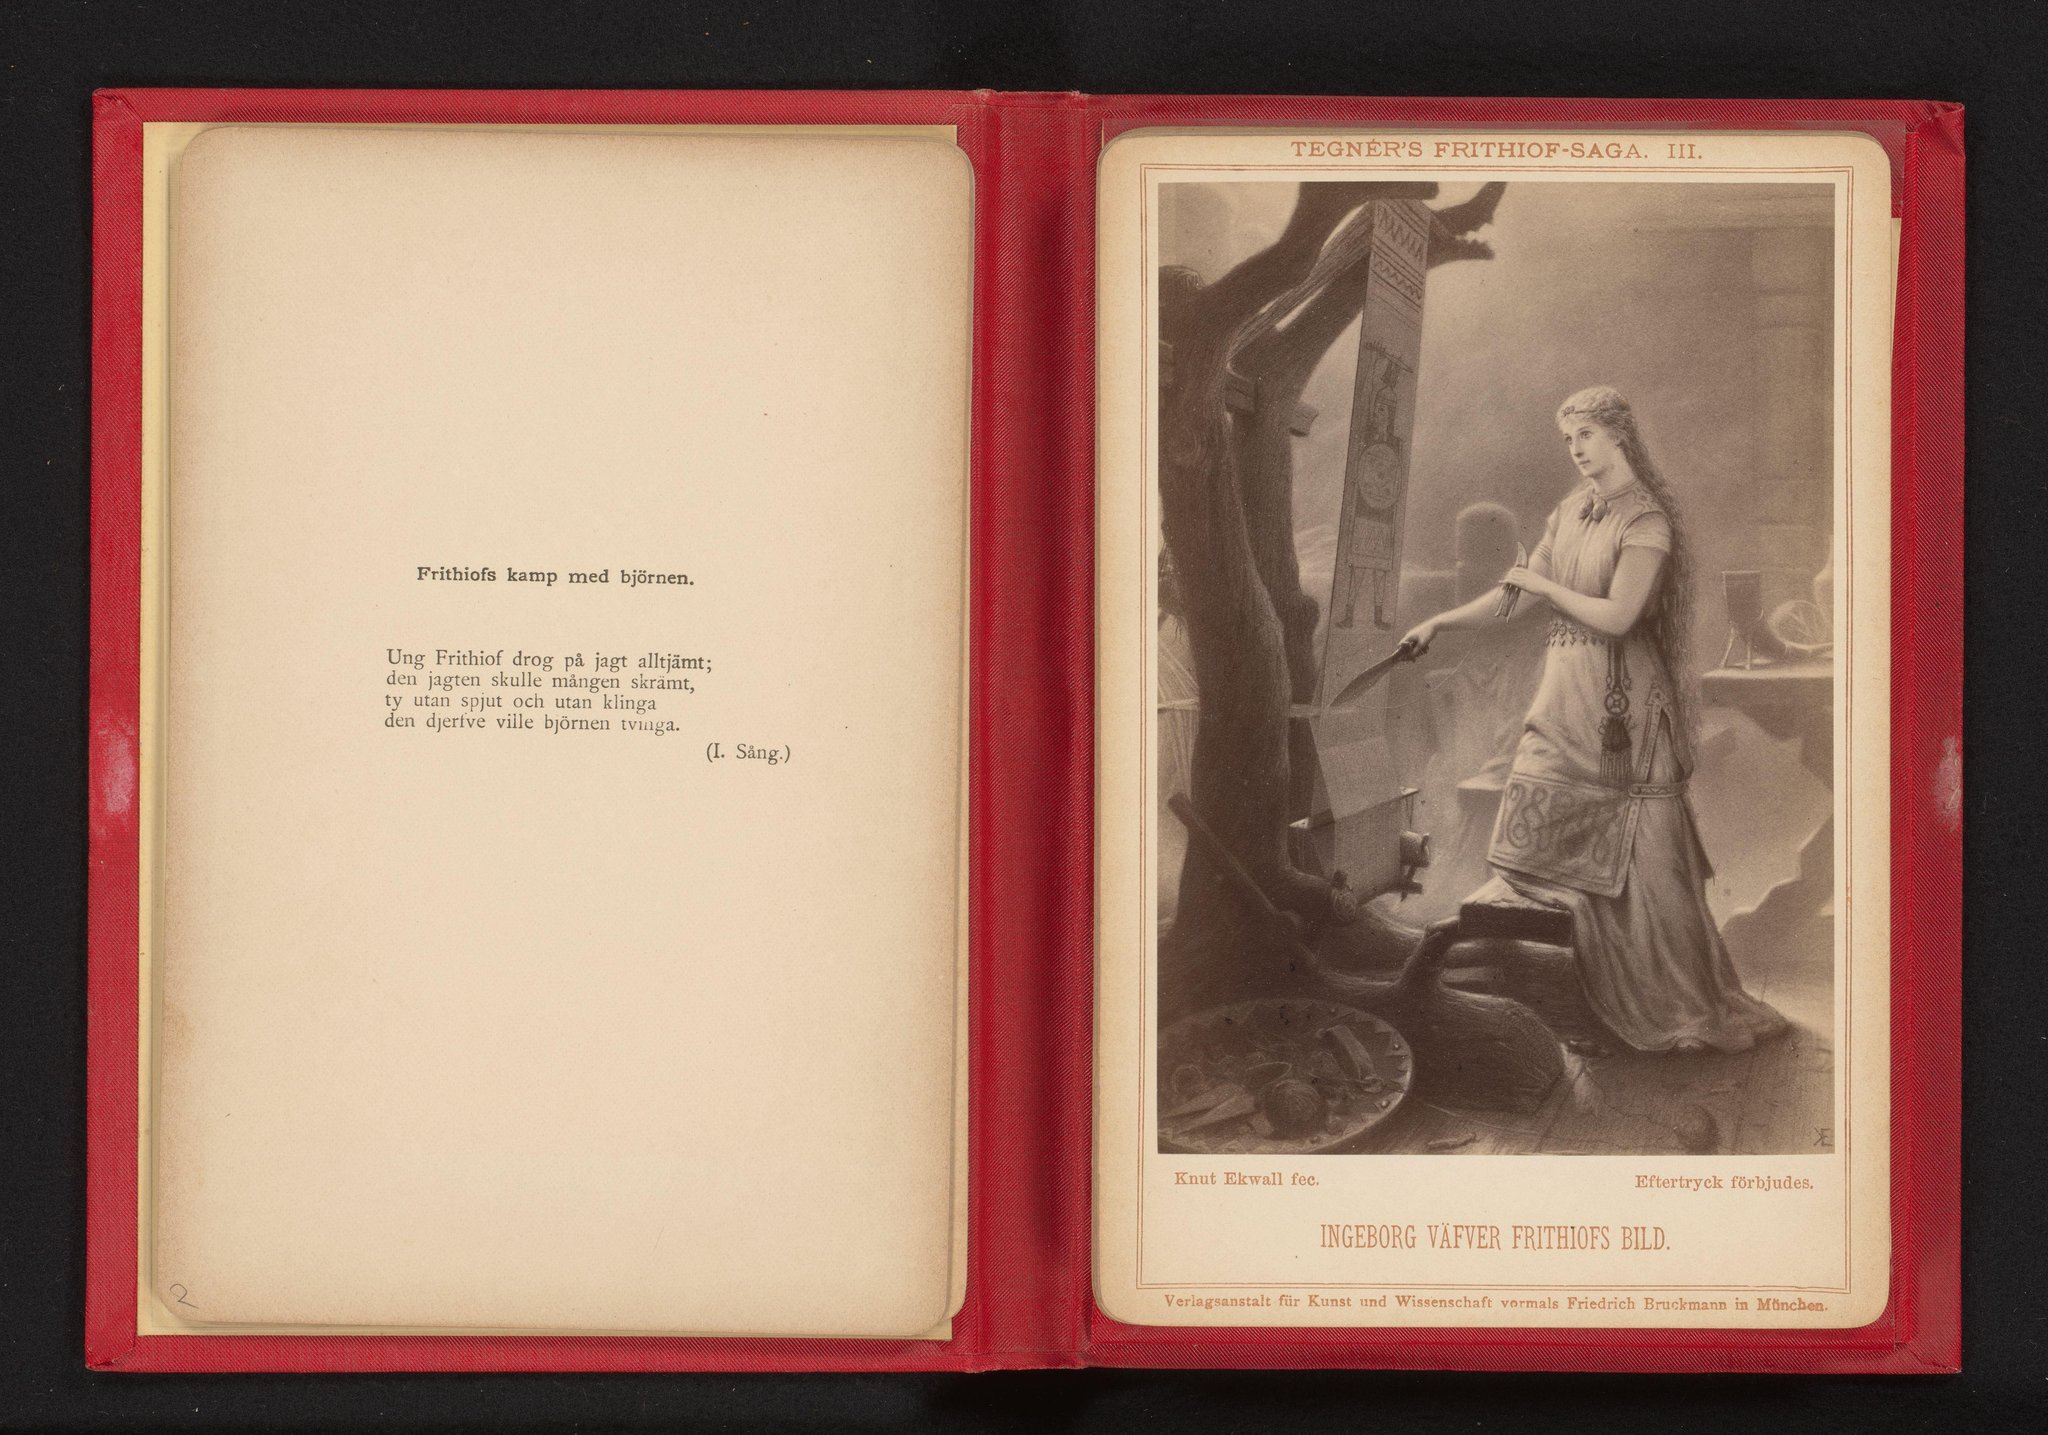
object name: photograph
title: Ingeborg väfver Frithiofs bild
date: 1874-1884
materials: photographic support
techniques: albumen print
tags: adult woman, weaving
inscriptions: number: ‘III.’